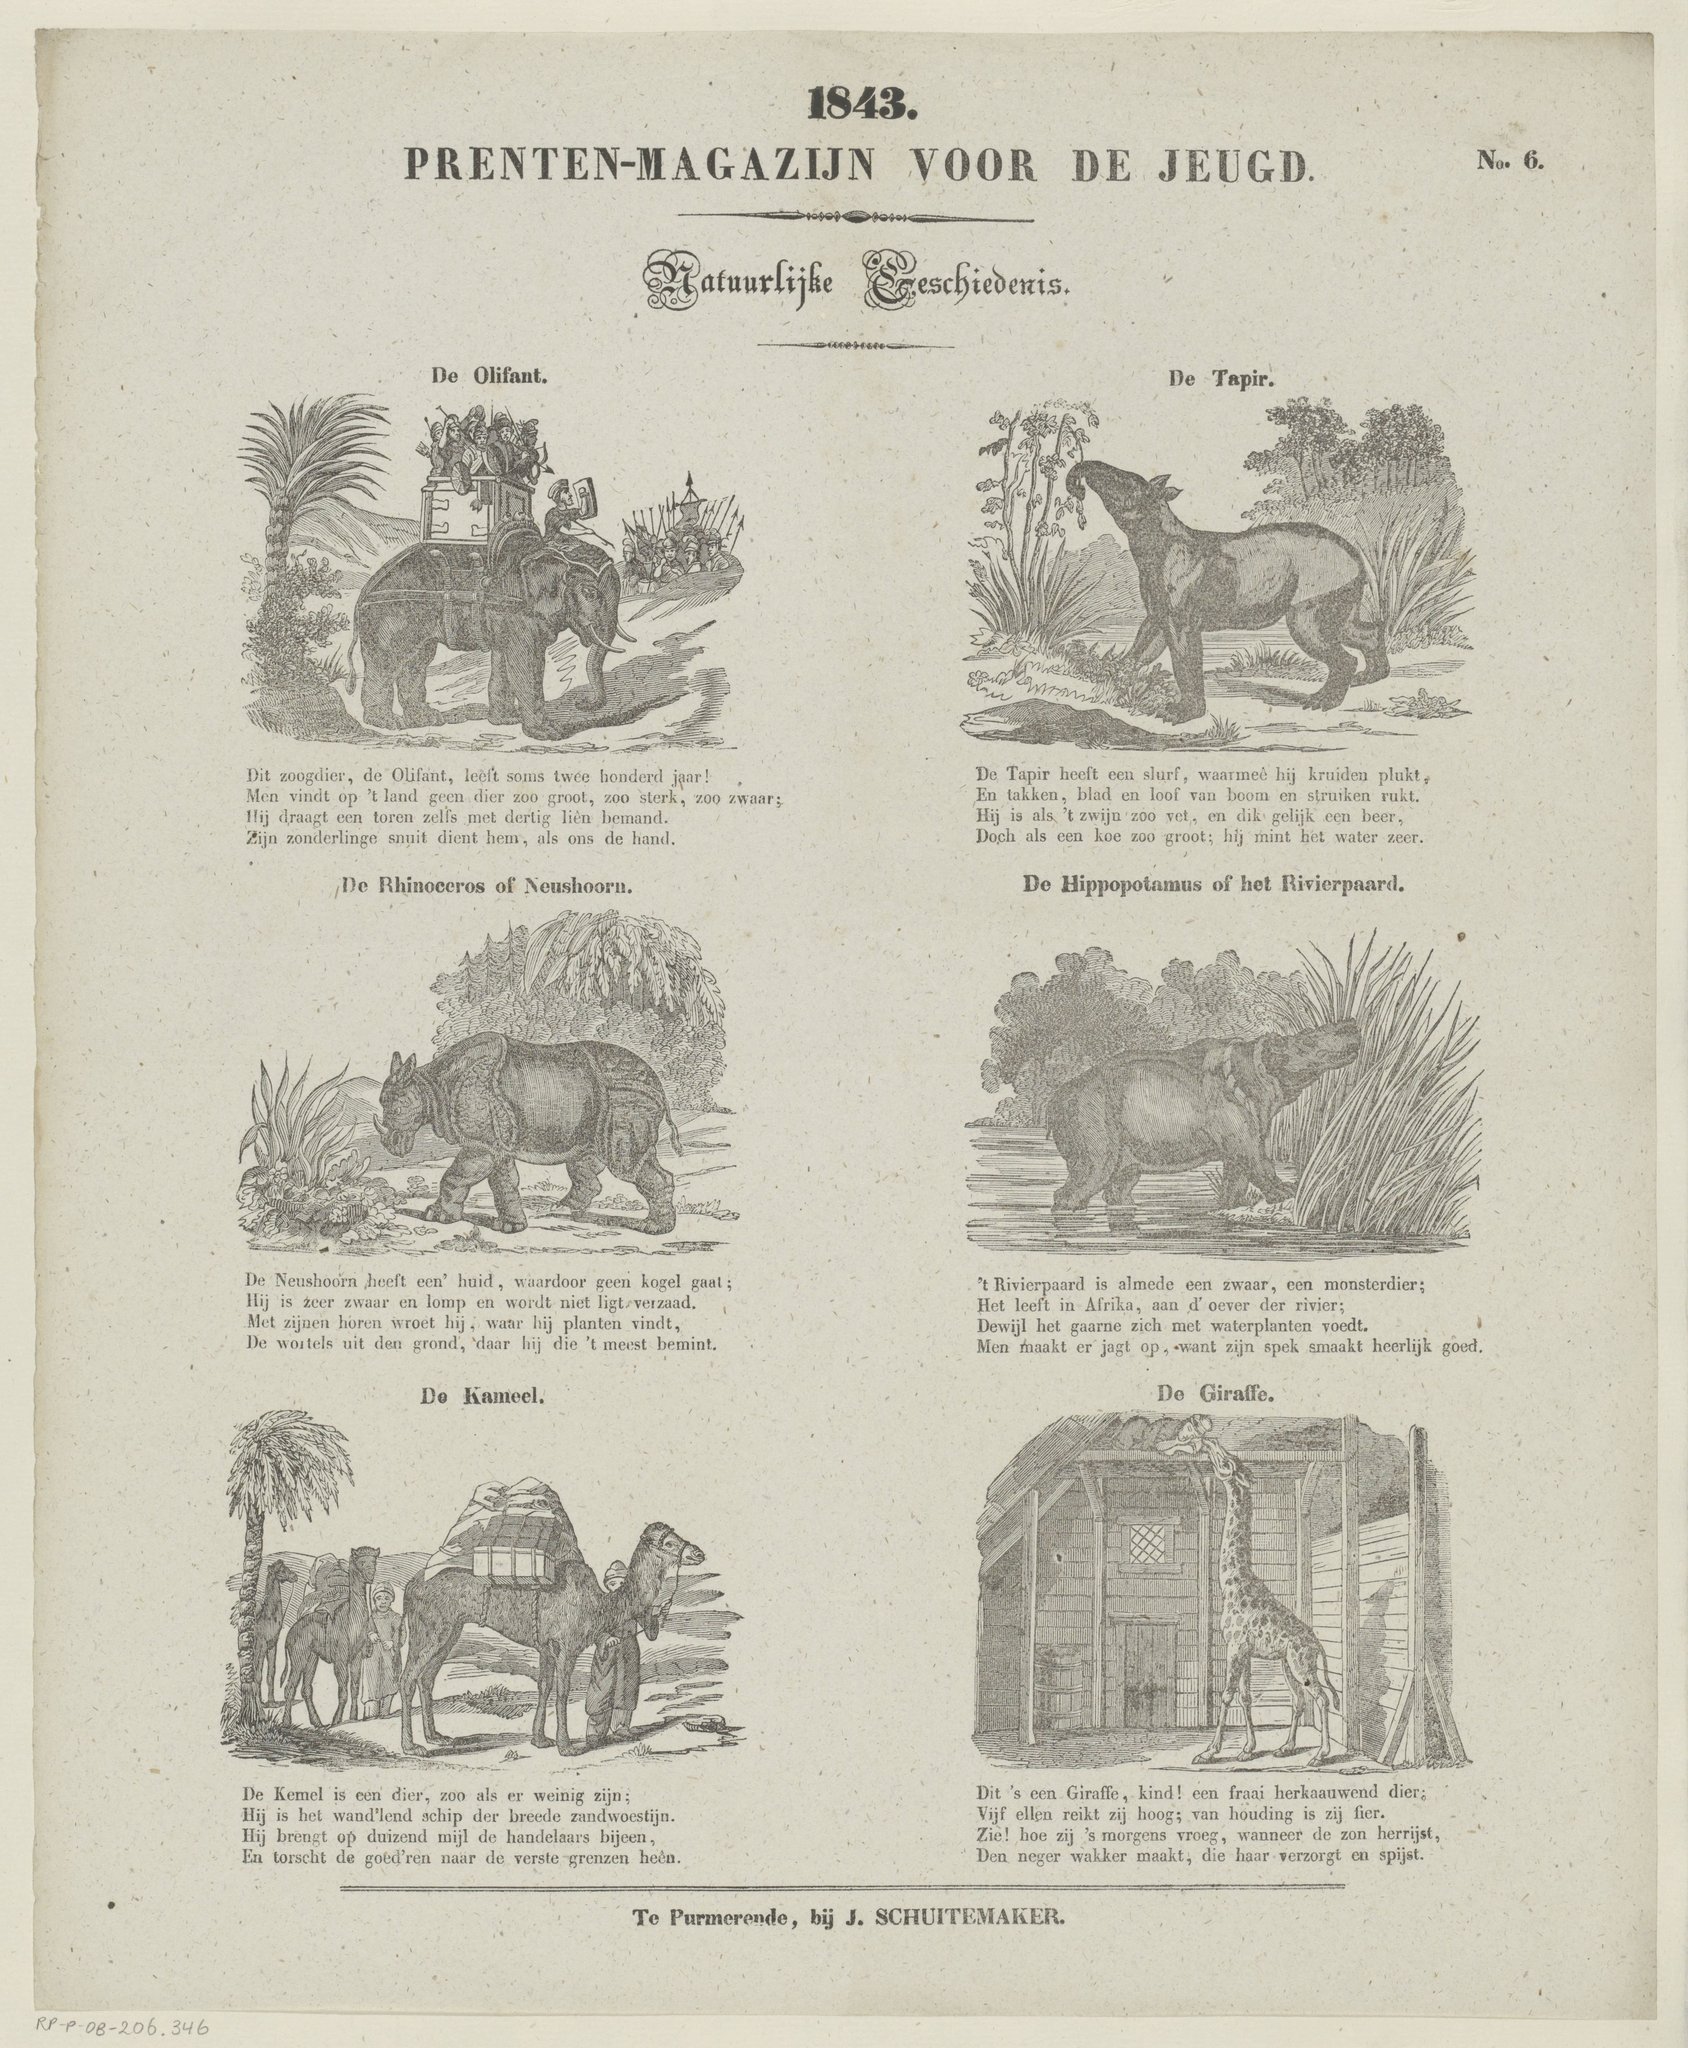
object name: popular print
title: Dieren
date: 1843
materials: paper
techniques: letterpress printing, engraving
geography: purmerend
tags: hoofed animals: camel, hoofed animals: hippopotamus, animals, hoofed animals: rhinoceros, hoofed animals: giraffe, trunked animals: elephant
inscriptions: collector's mark: Lugt 2760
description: Blad met 6 voorstellingen van verschillende dieren: een olifant, een tapir, een neushoorn, een nijlpaard, een kameel en een giraffe. Boven elke voorstelling een titel en onder elke voorstelling een vierregelig vers. Genummerd rechtsboven: No. 6.